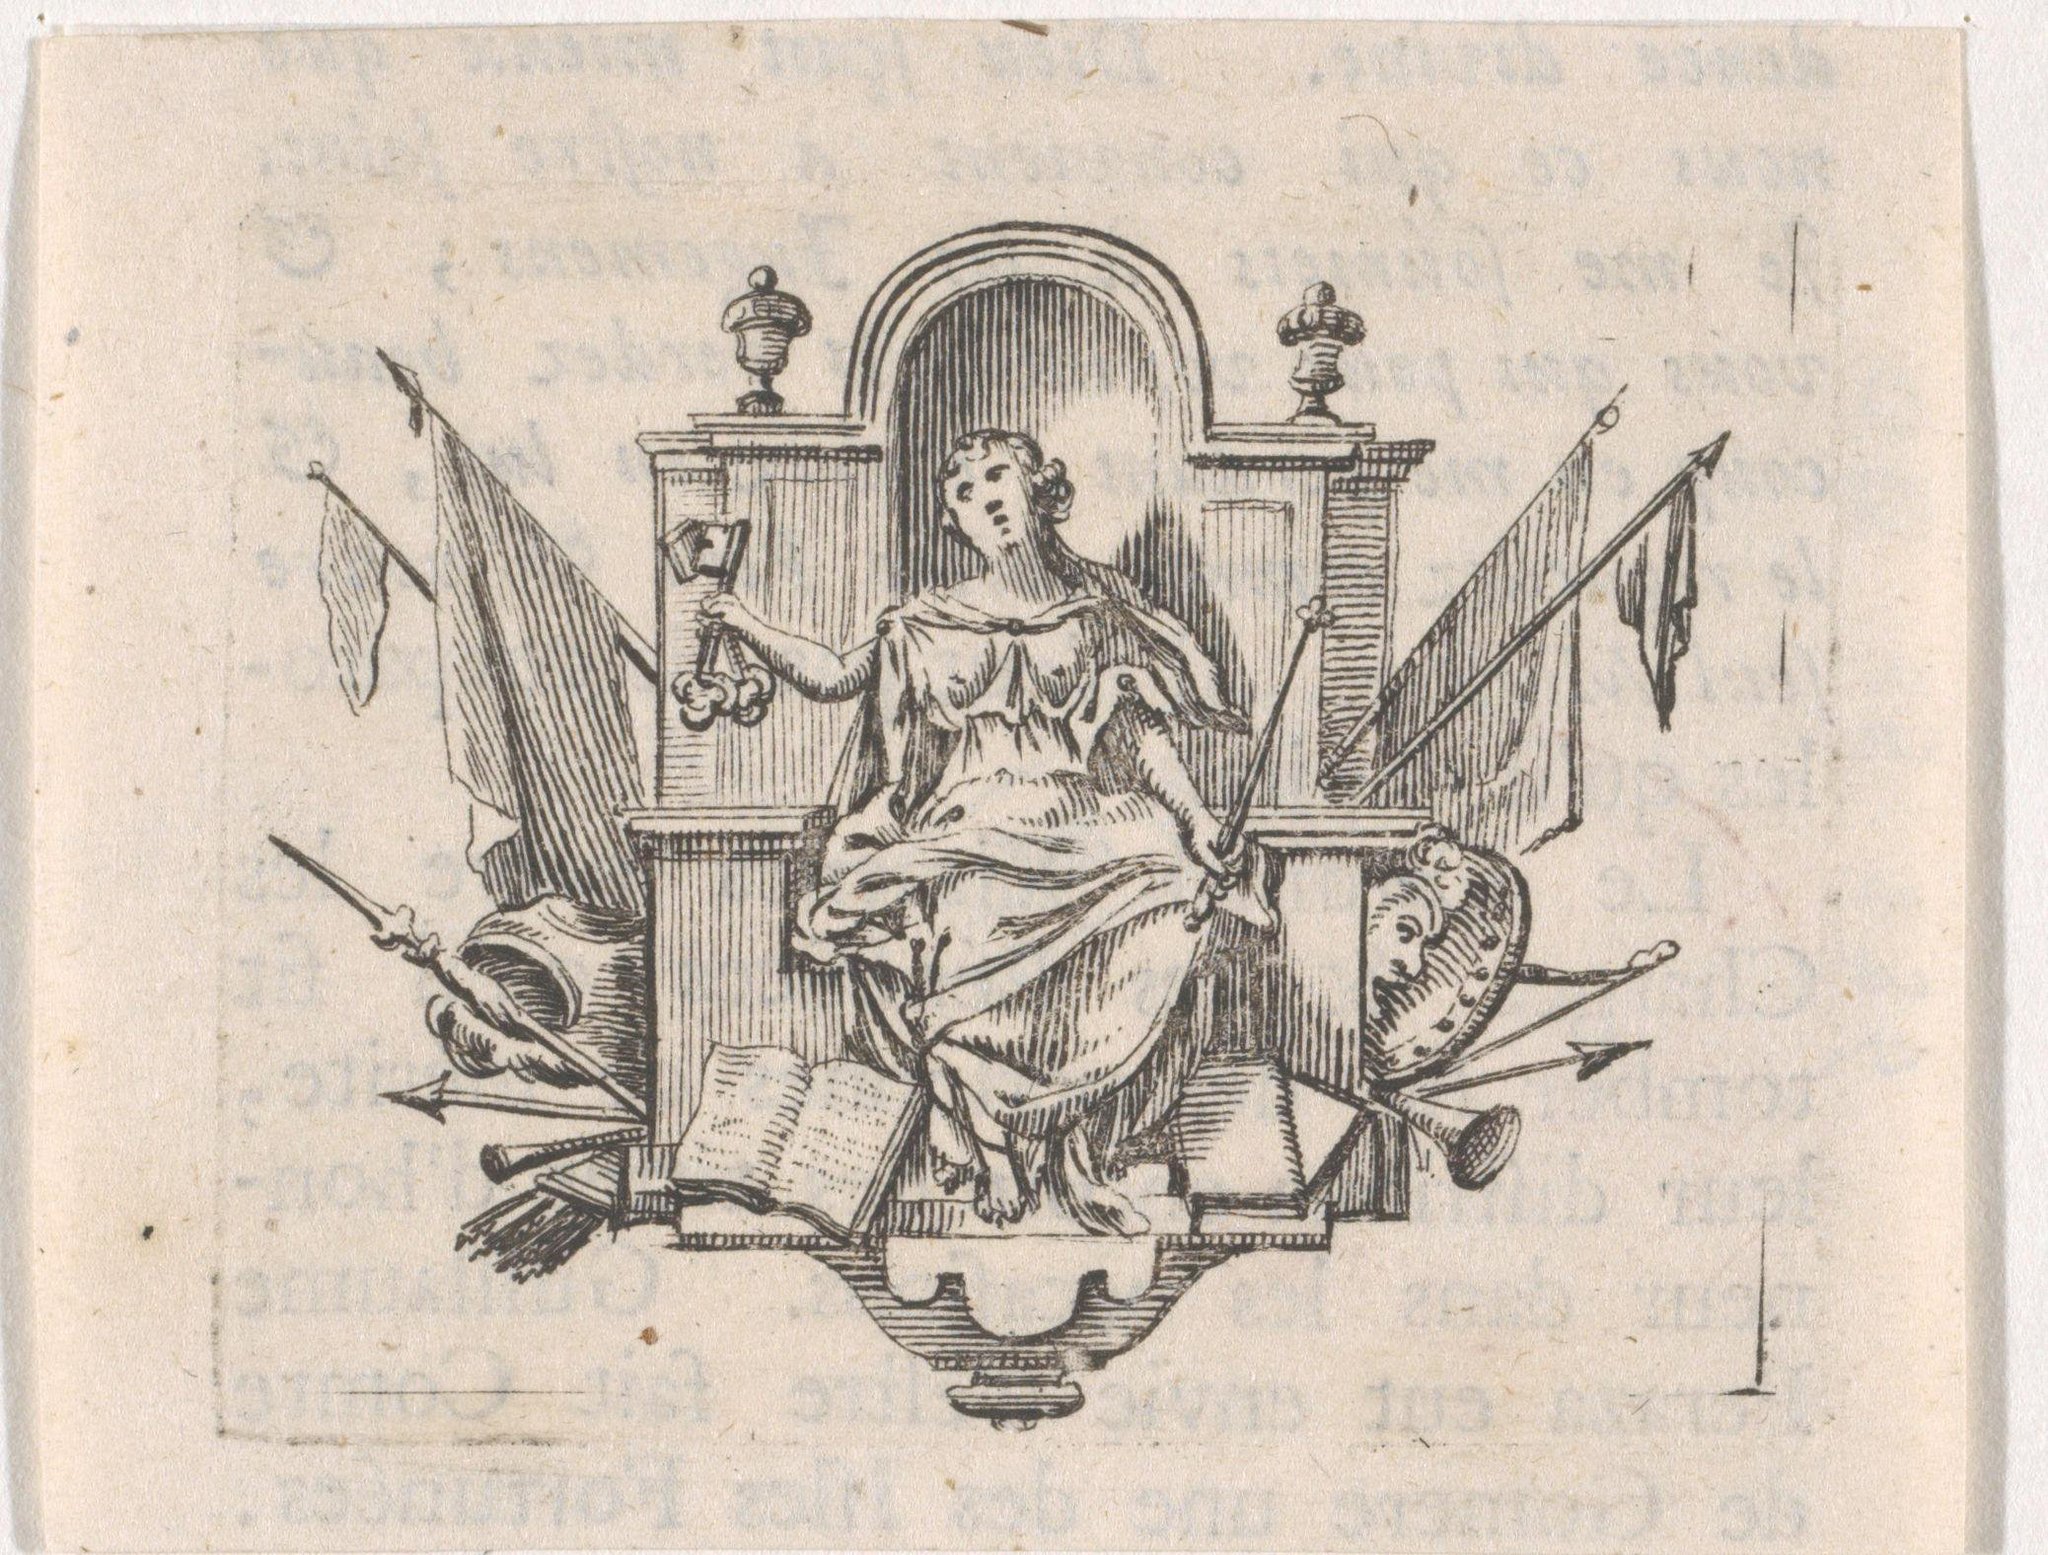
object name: print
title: Vignet met zittende vrouw met sleutels, scepter, boek en wapenrusting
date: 1620-1664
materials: paper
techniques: etching, letterpress printing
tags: armour, key, vignette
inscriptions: collector's mark: Lugt 240, collector's mark: Lugt 2228